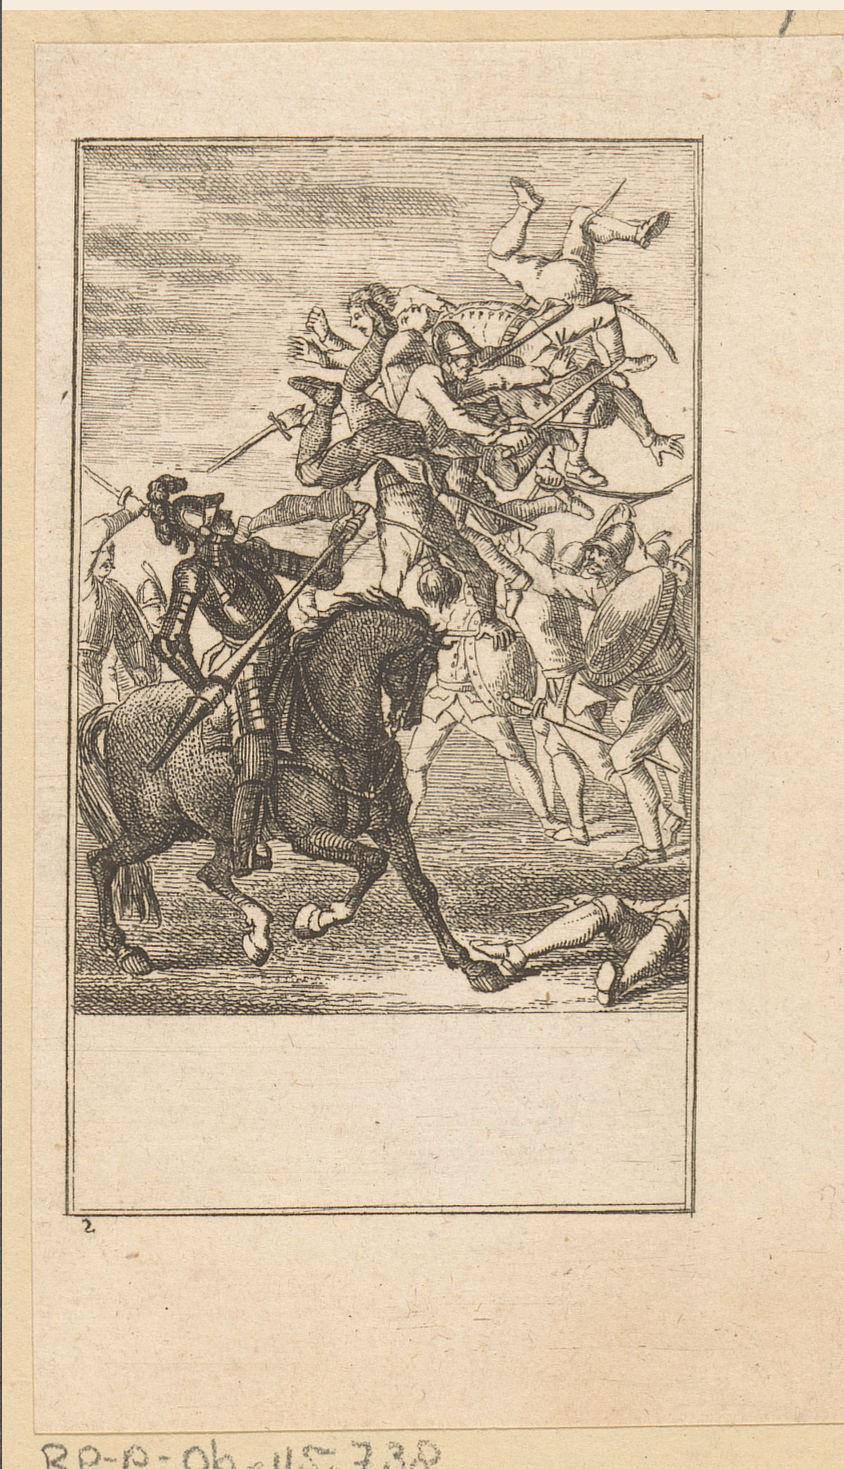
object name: print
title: Orlando verslaat in zijn razernij eigenhandig het leger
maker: louis wilhelm chodowiecki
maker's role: print maker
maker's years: 1765-1805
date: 1771-1772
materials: paper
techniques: etching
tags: battle, rage, anger, (scenes from) specific works of literature: ariosto, orlando furioso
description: Vervaardigd voor Orlando Furioso van Ludovico Ariosto. Prent gebruikt voor: Almanac Genealogique pour l'année 1772. Berlijn: s.n.s.a.